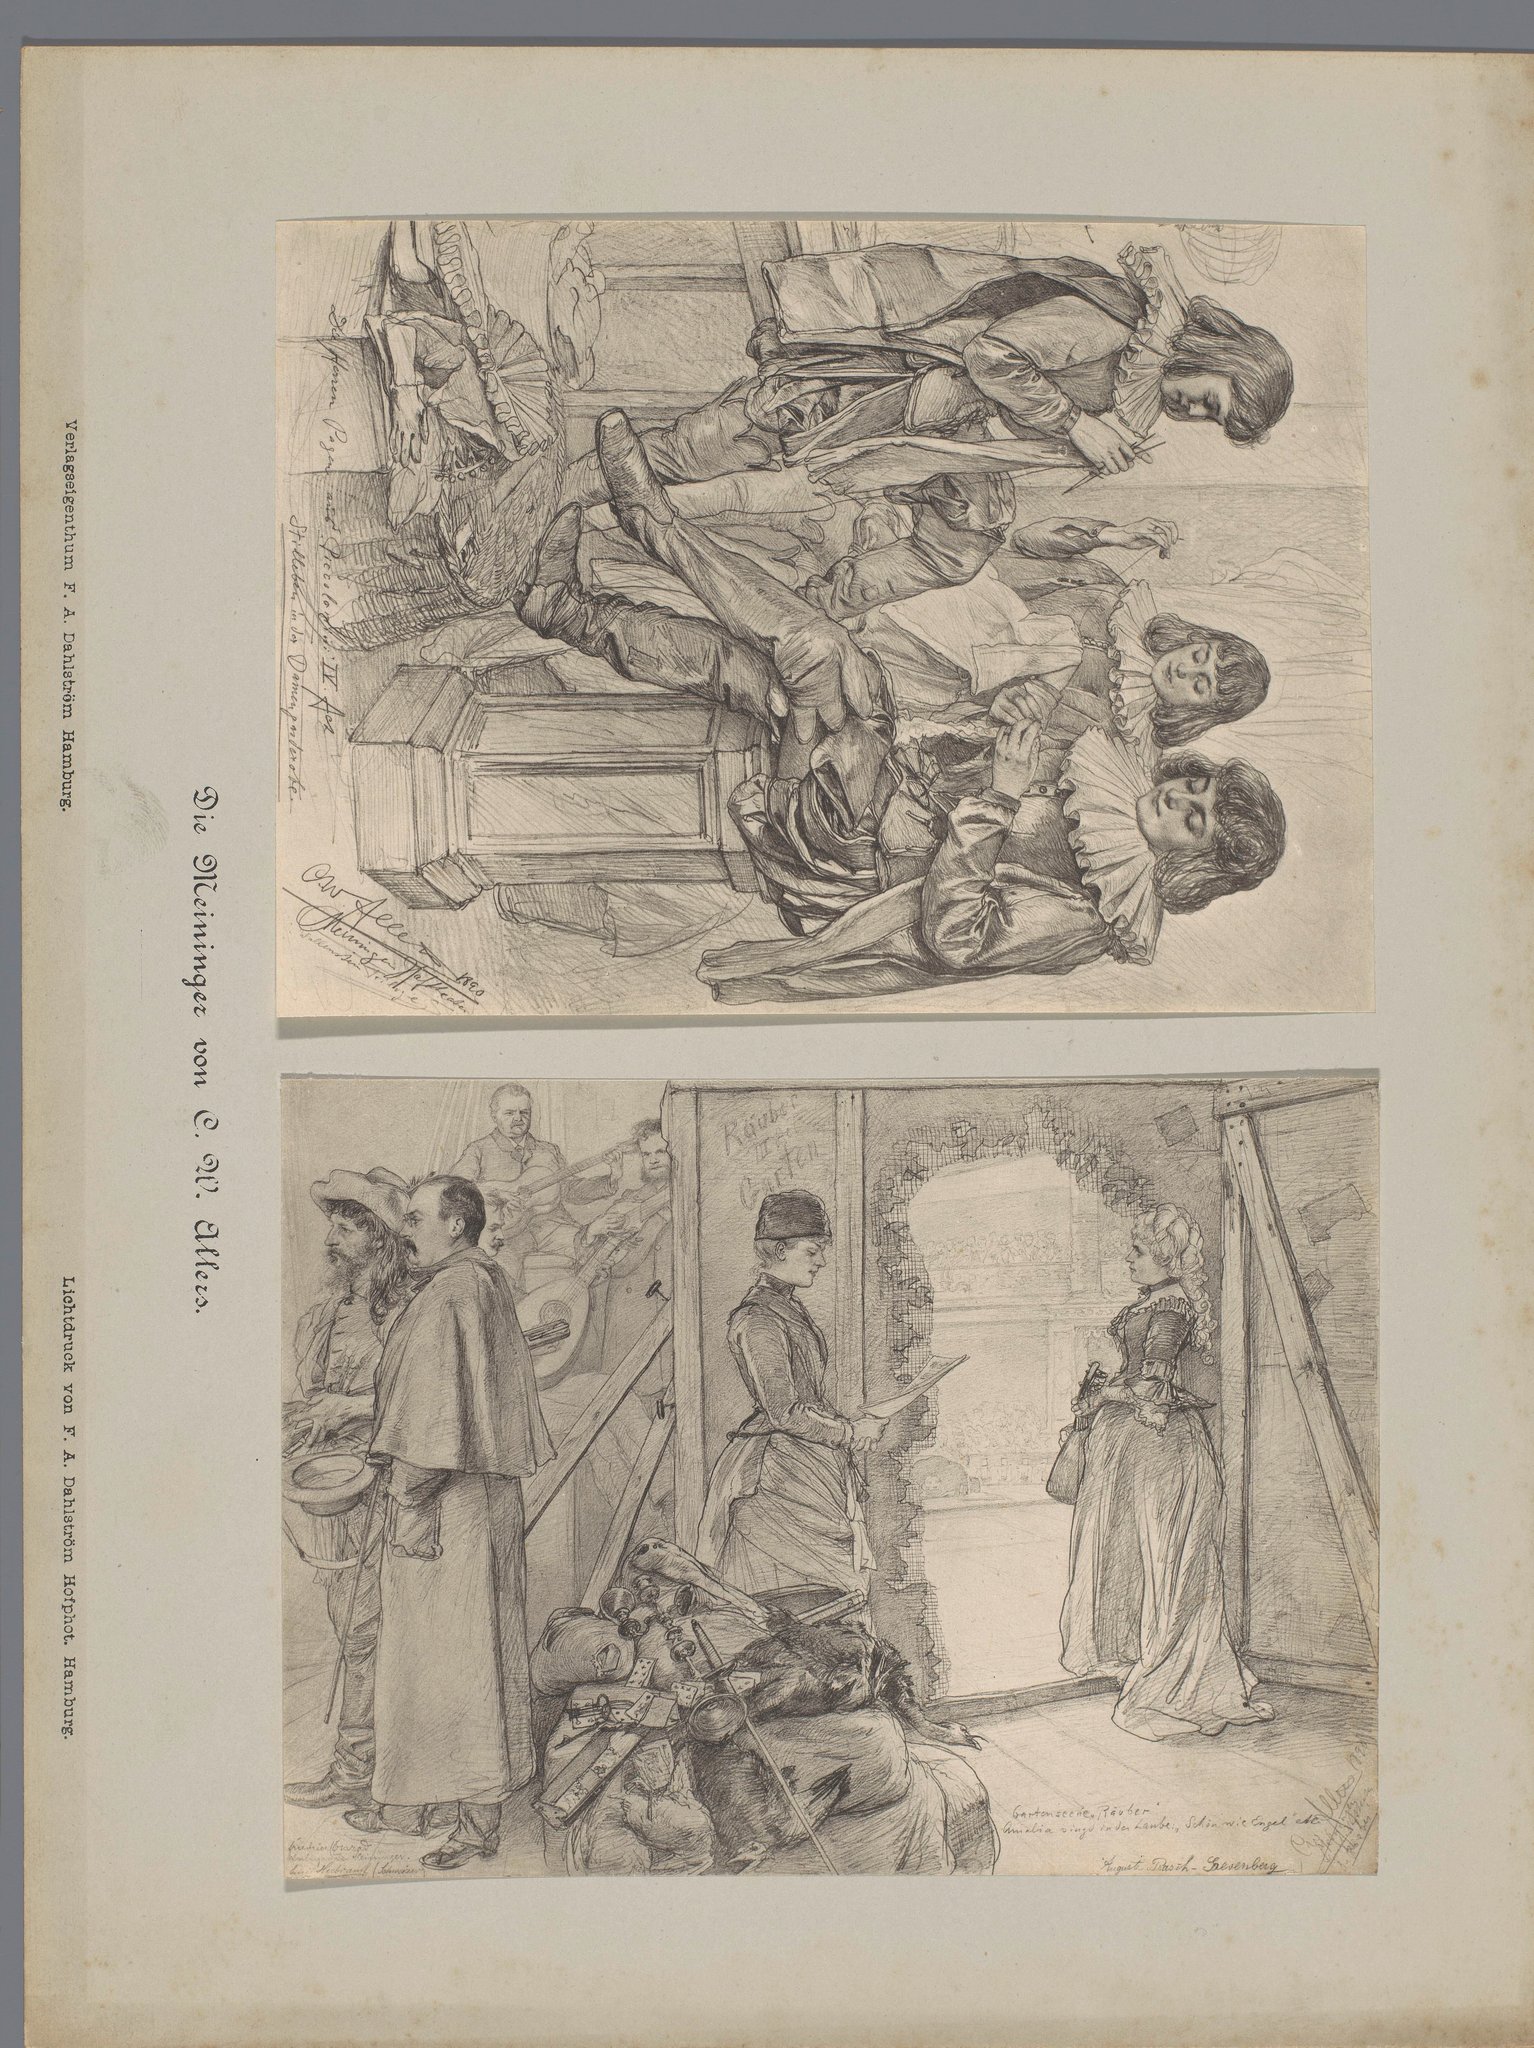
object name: reproduction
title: Twee fotoreproducties van tekeningen, voorstellende drie actrices in pagekostuum naaien kleding en een actrice zingt een lied tijdens een opvoering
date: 1890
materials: paper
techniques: photograph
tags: theatre, theatrical performance, portrait of actor, actress, sewing